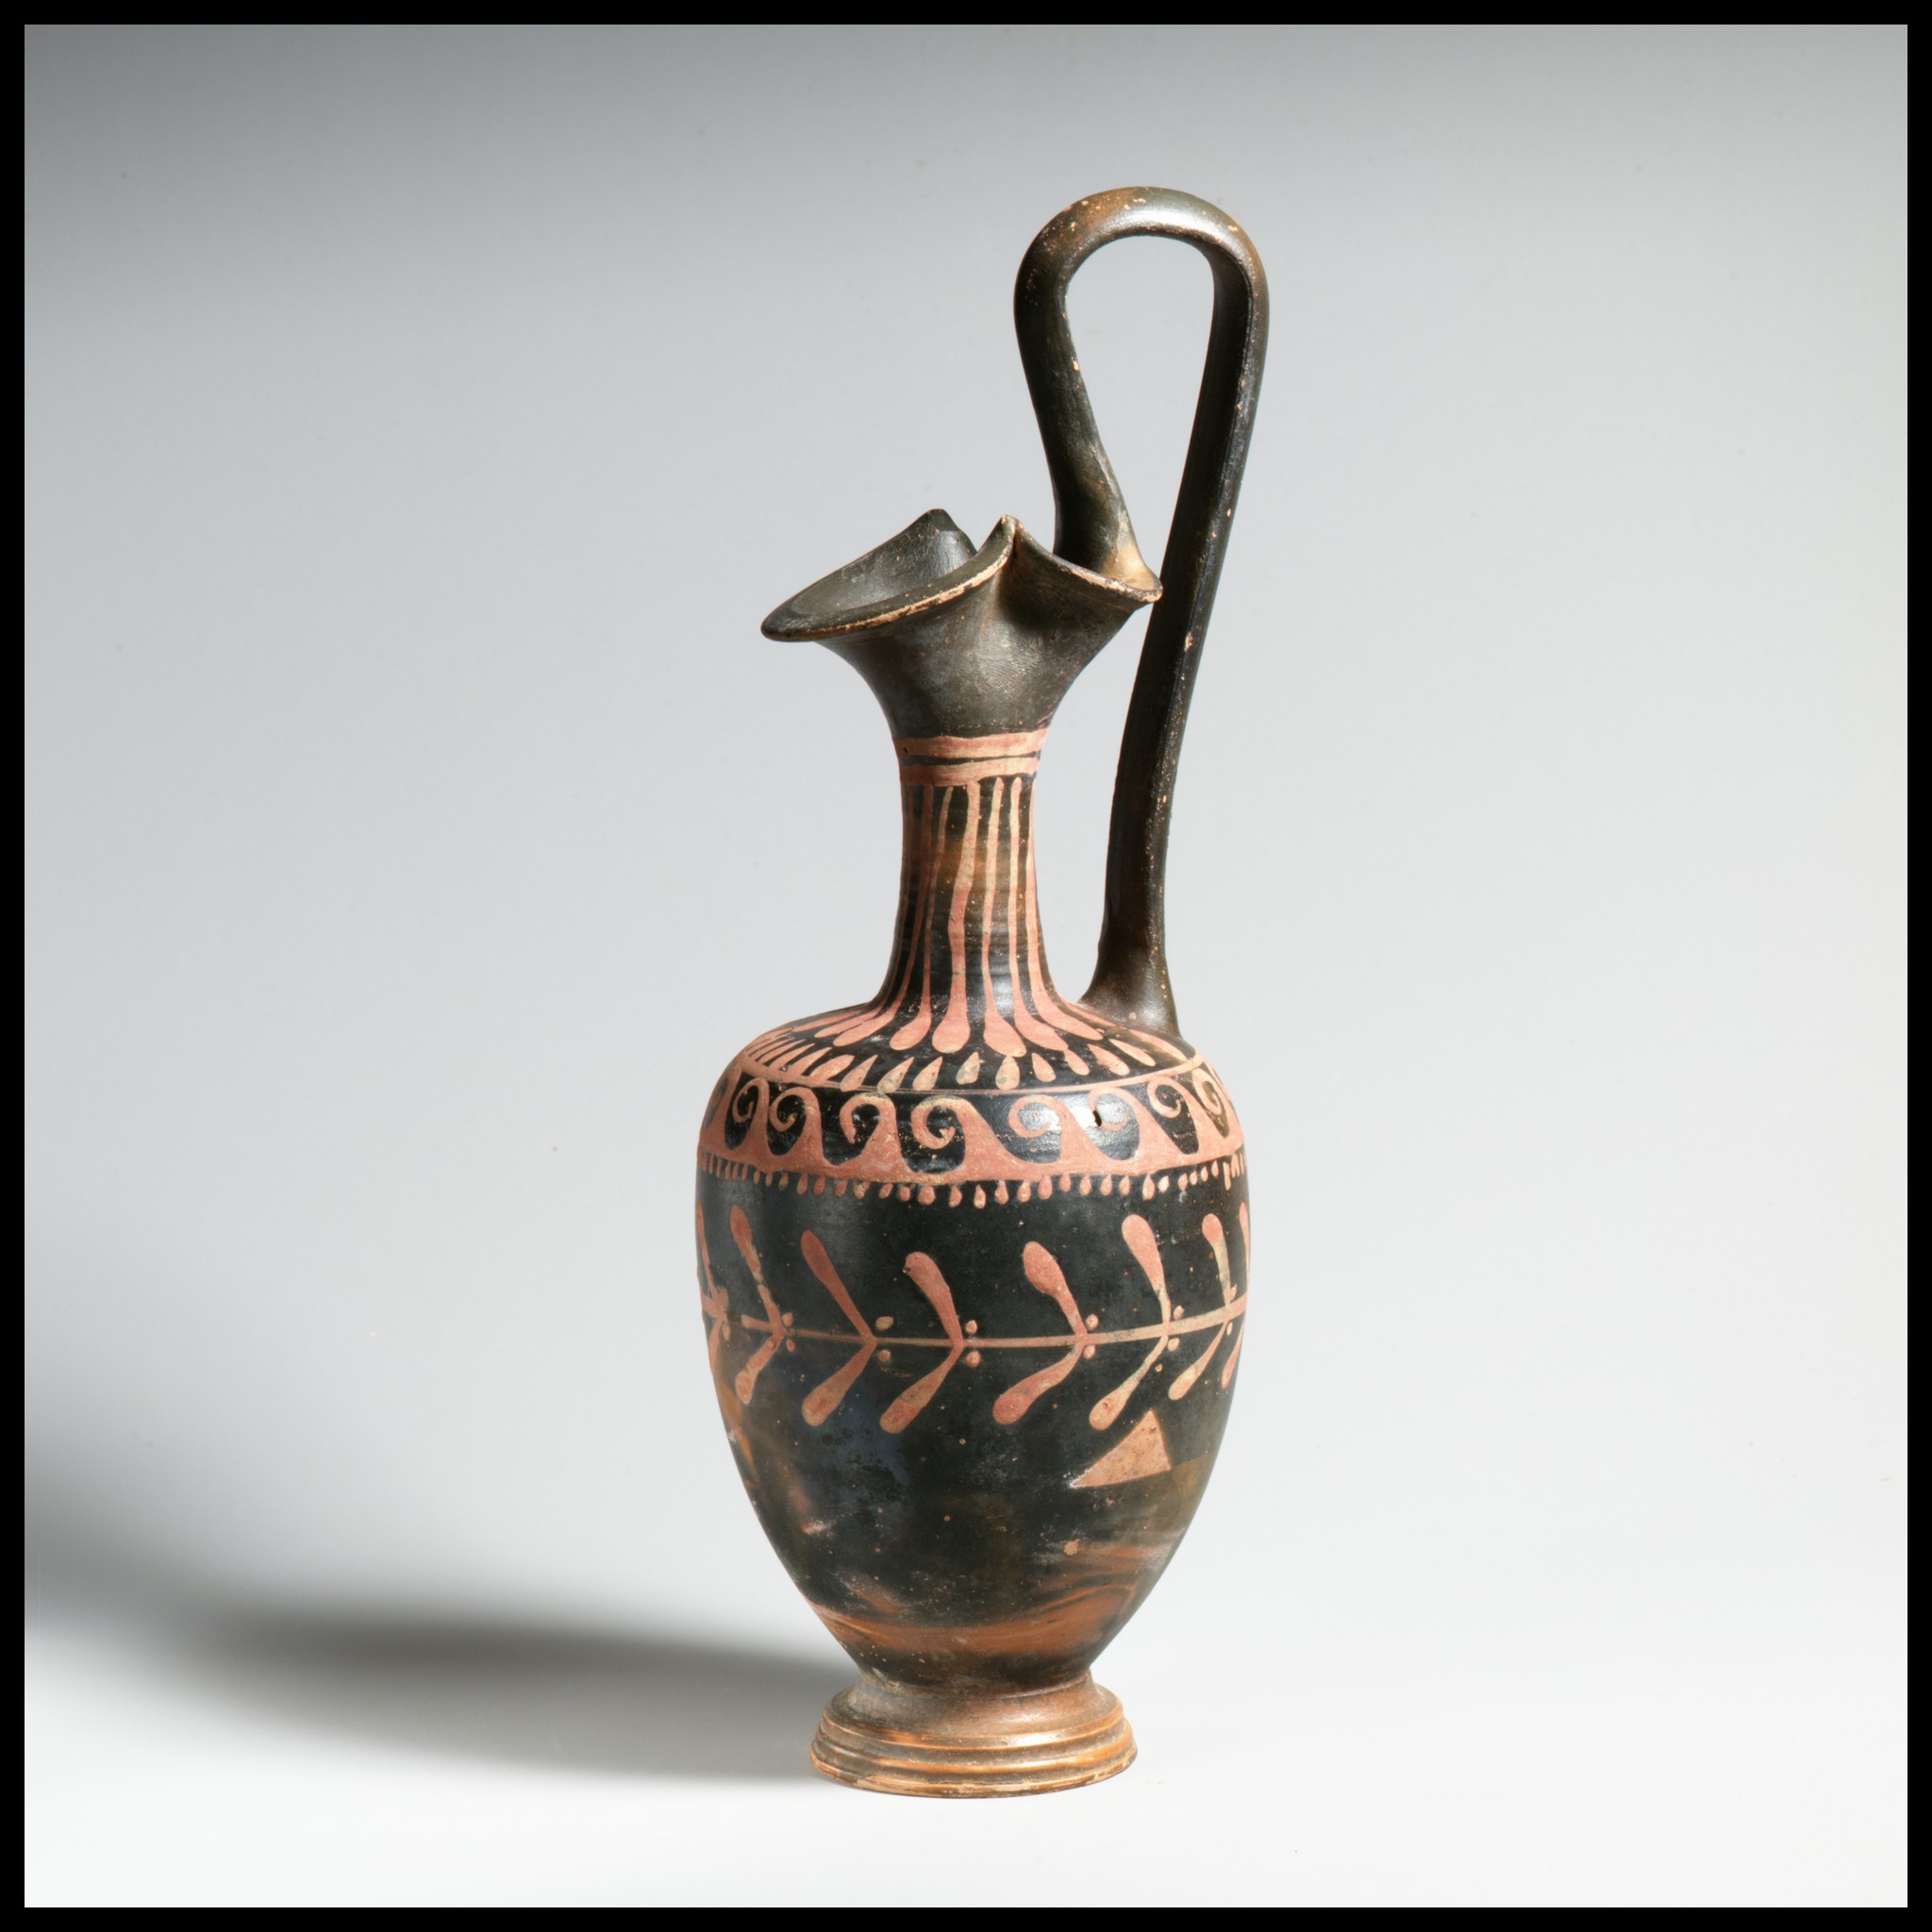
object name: oinochoe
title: Terracotta oinochoe (jug)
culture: greek or south italian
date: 334-268 BCE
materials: terracotta